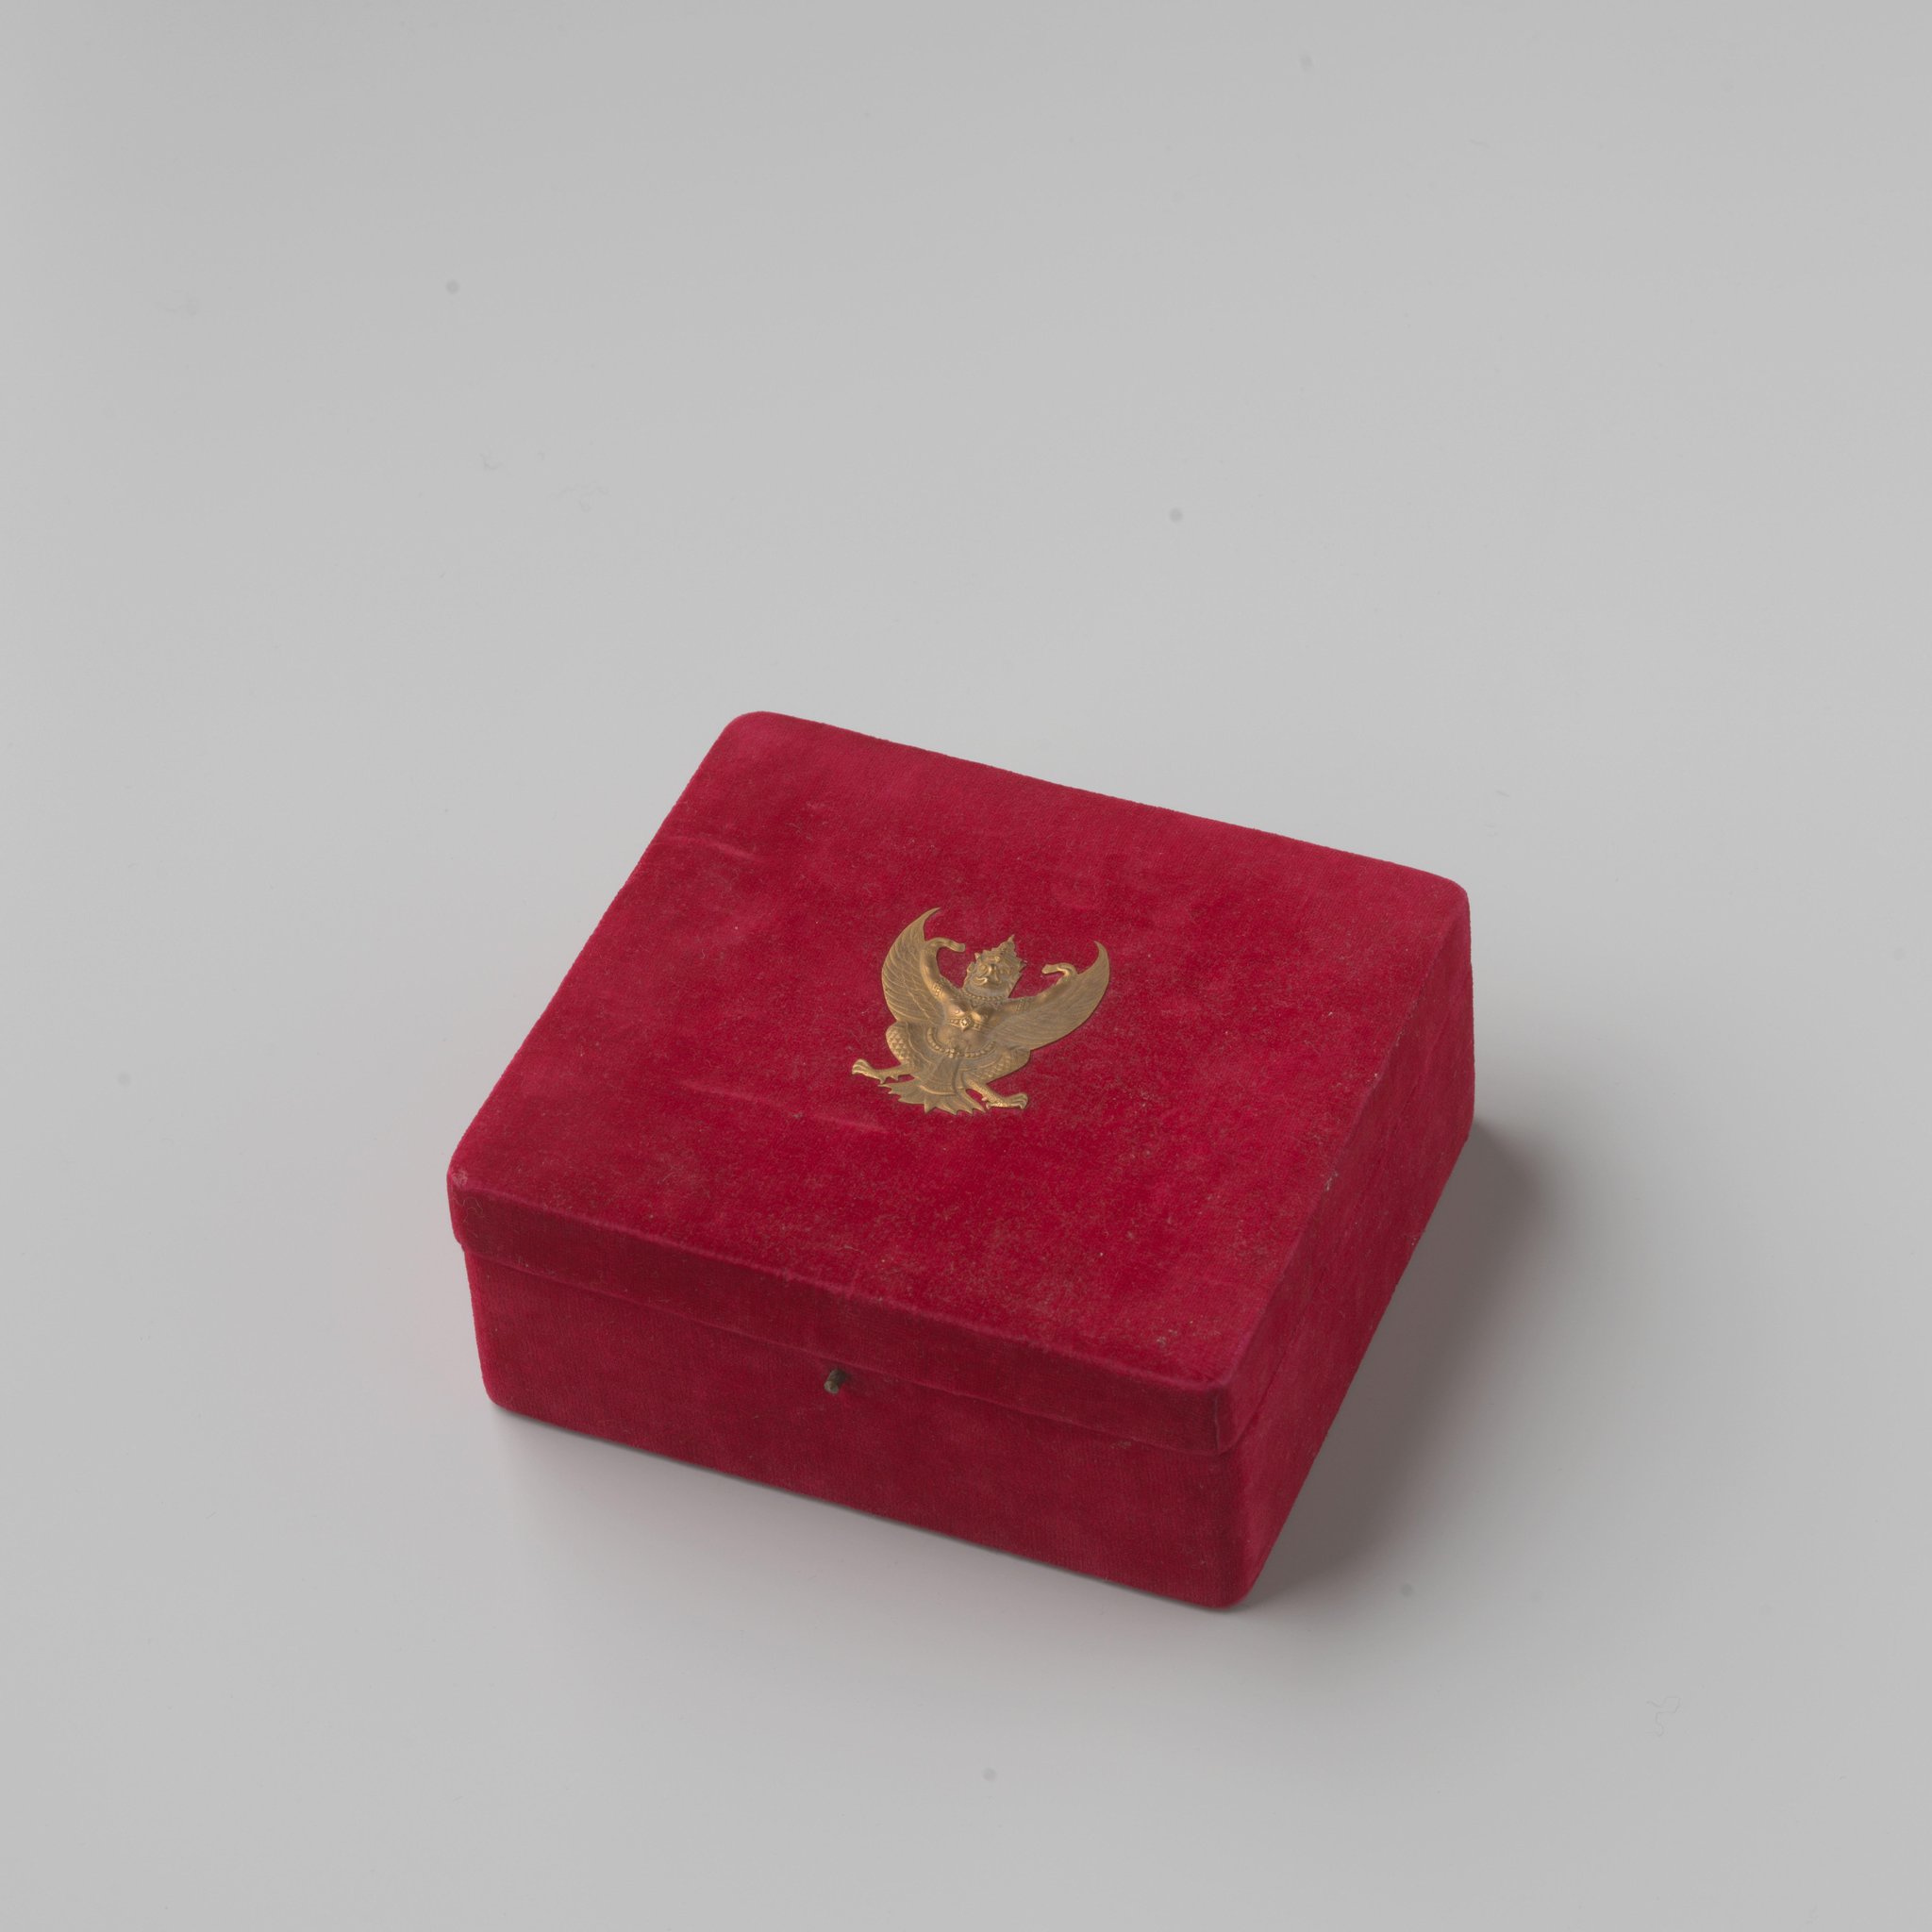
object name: box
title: Doos met rood fluweel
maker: Anonymous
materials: copper, textile, velvet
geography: bangkok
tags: amsterdam, the hague, willem drees, netherlands, thailand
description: Met rood fluweel beklede doos. De binnenkant van de doos is bekleedt met witte stof. De binnenzijde van de deksel is met witte zijde gevoerd en bevat een stempel 'Sahasinpa [...] Bangkok'.